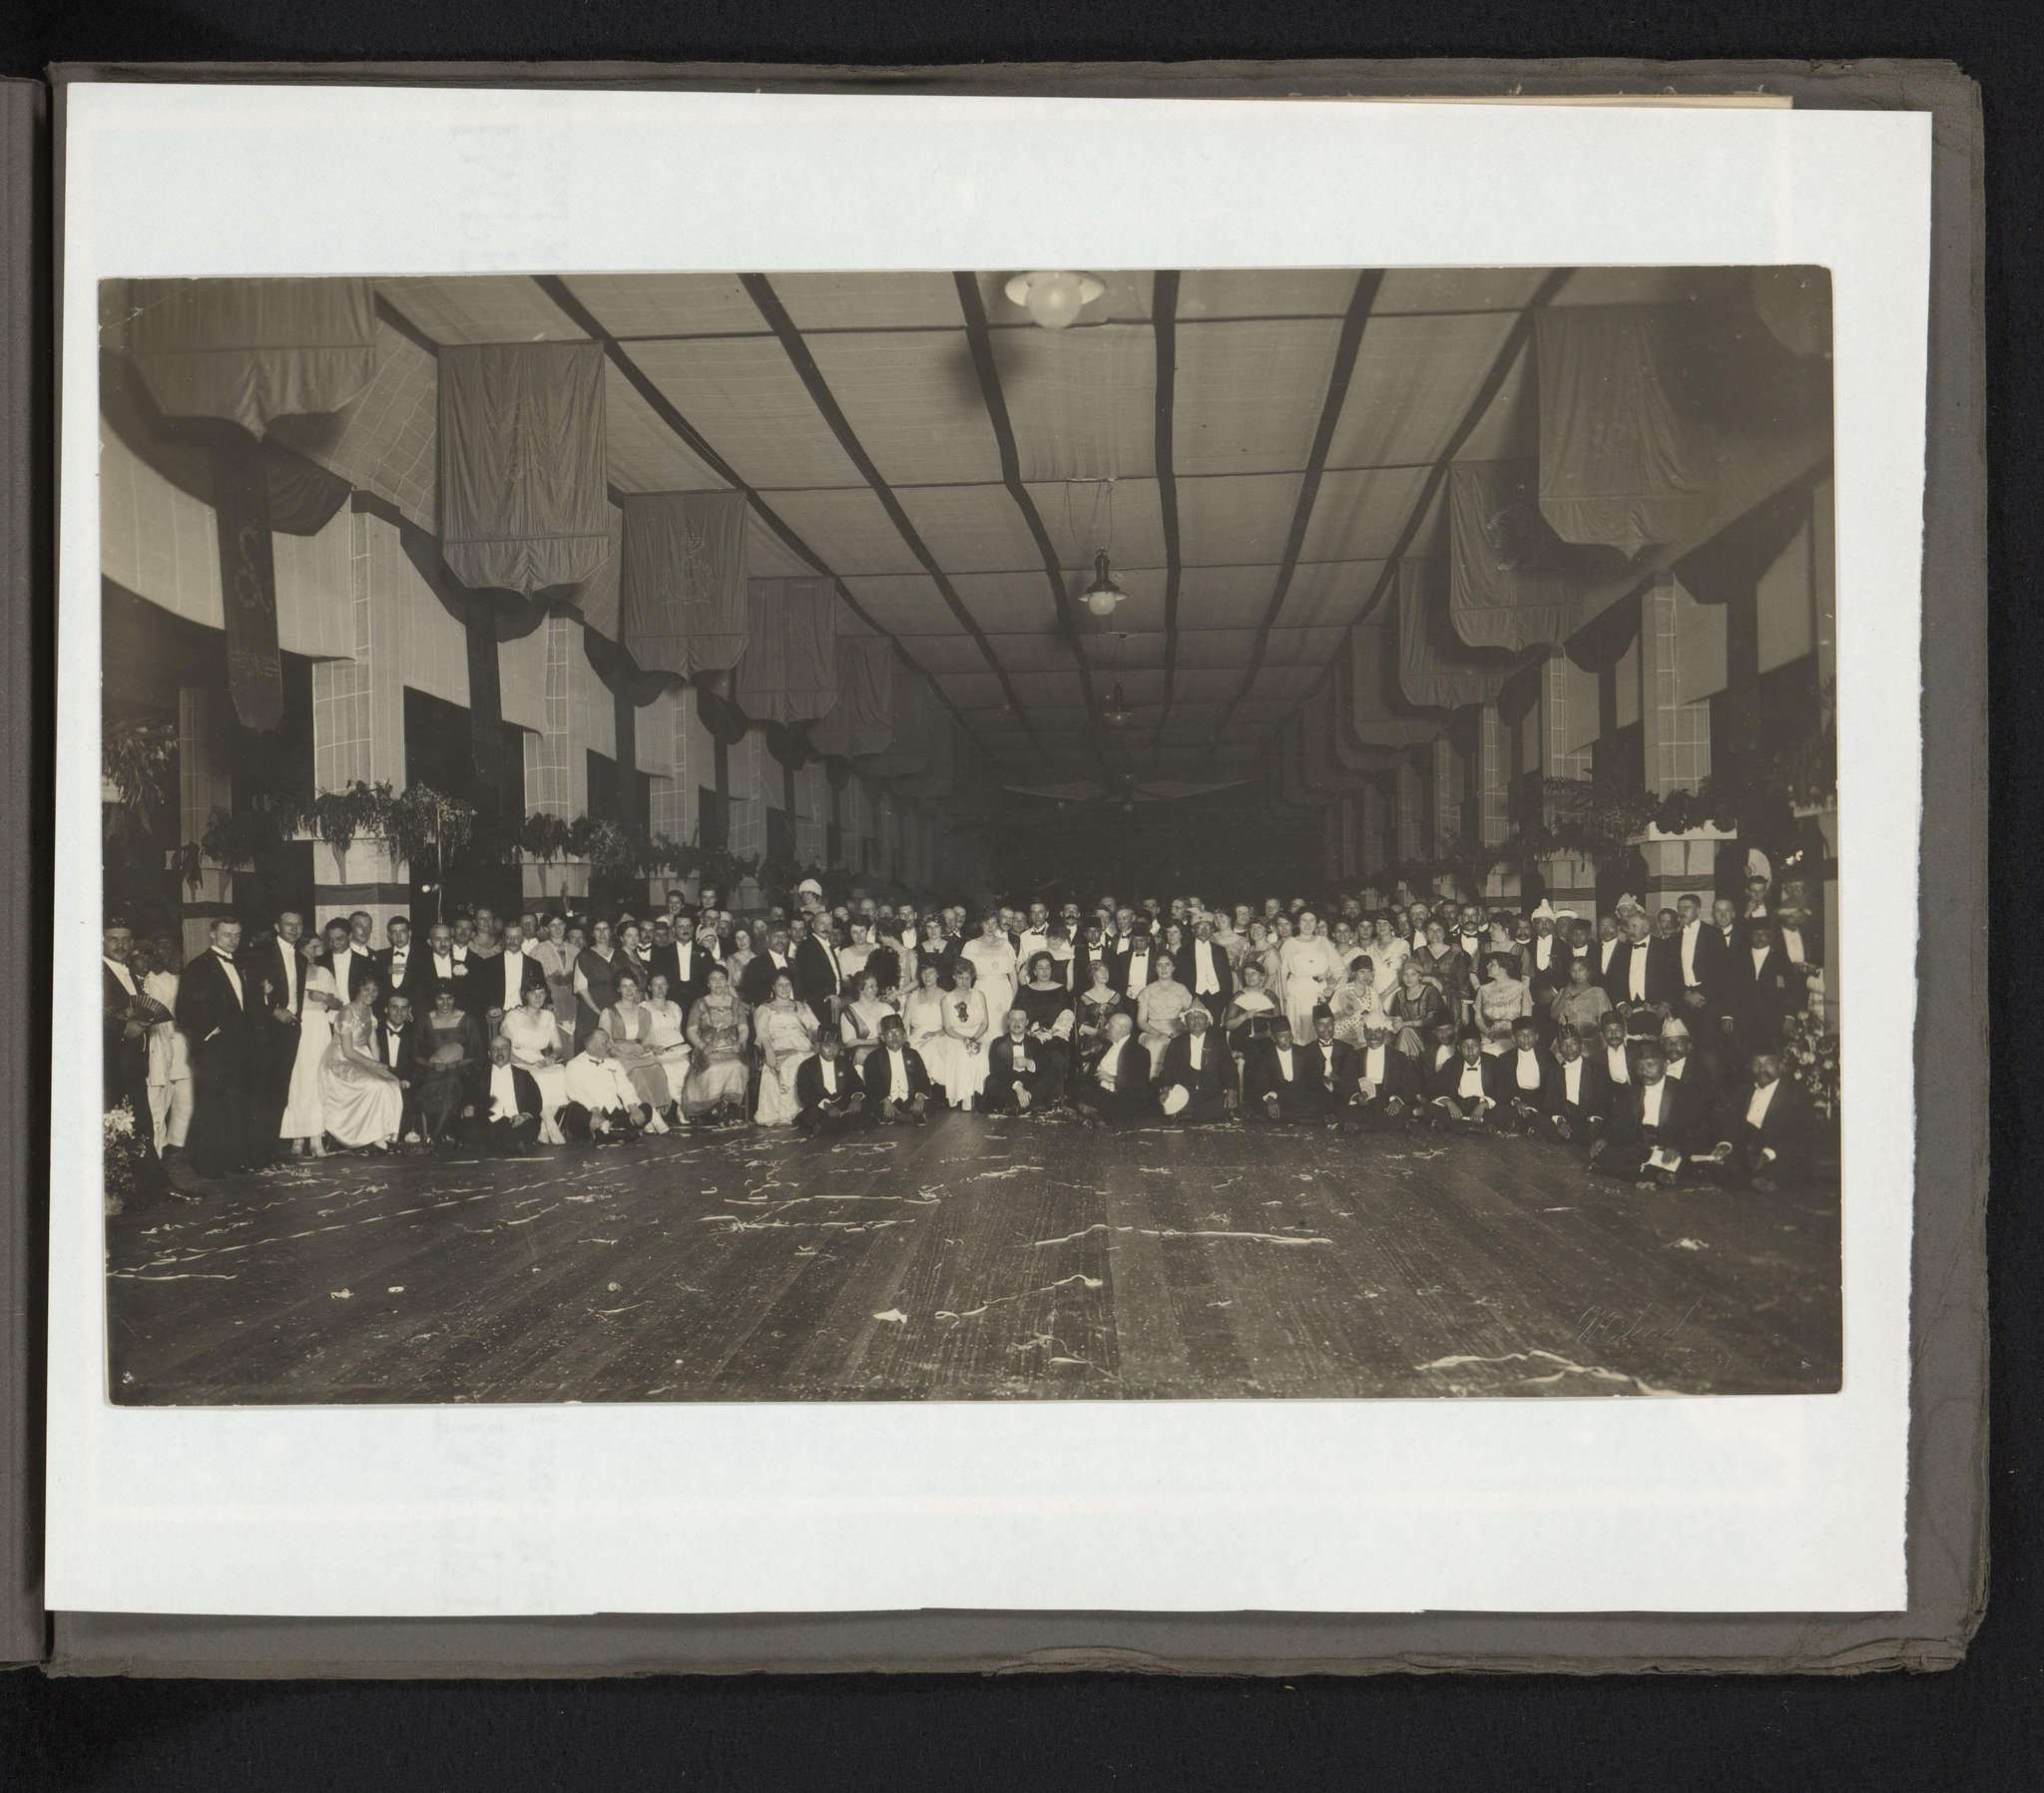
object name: photograph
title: Groepsportret met onder andere Albert Glaser, bij het 25-jarige jubileum in het paleis van de Sultan van Langkat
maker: mikado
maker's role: fotograaf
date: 1919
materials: photographic support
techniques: gelatin silver print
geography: tandjong poera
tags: palace - aa - civic architecture: inside, historical persons, sumatra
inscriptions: annotation: ‘Sultan van Langkat/ 25 Jahr Jubiläum/ 23.5.1919/ Emma [...] rechts von Tante Emma [...]’